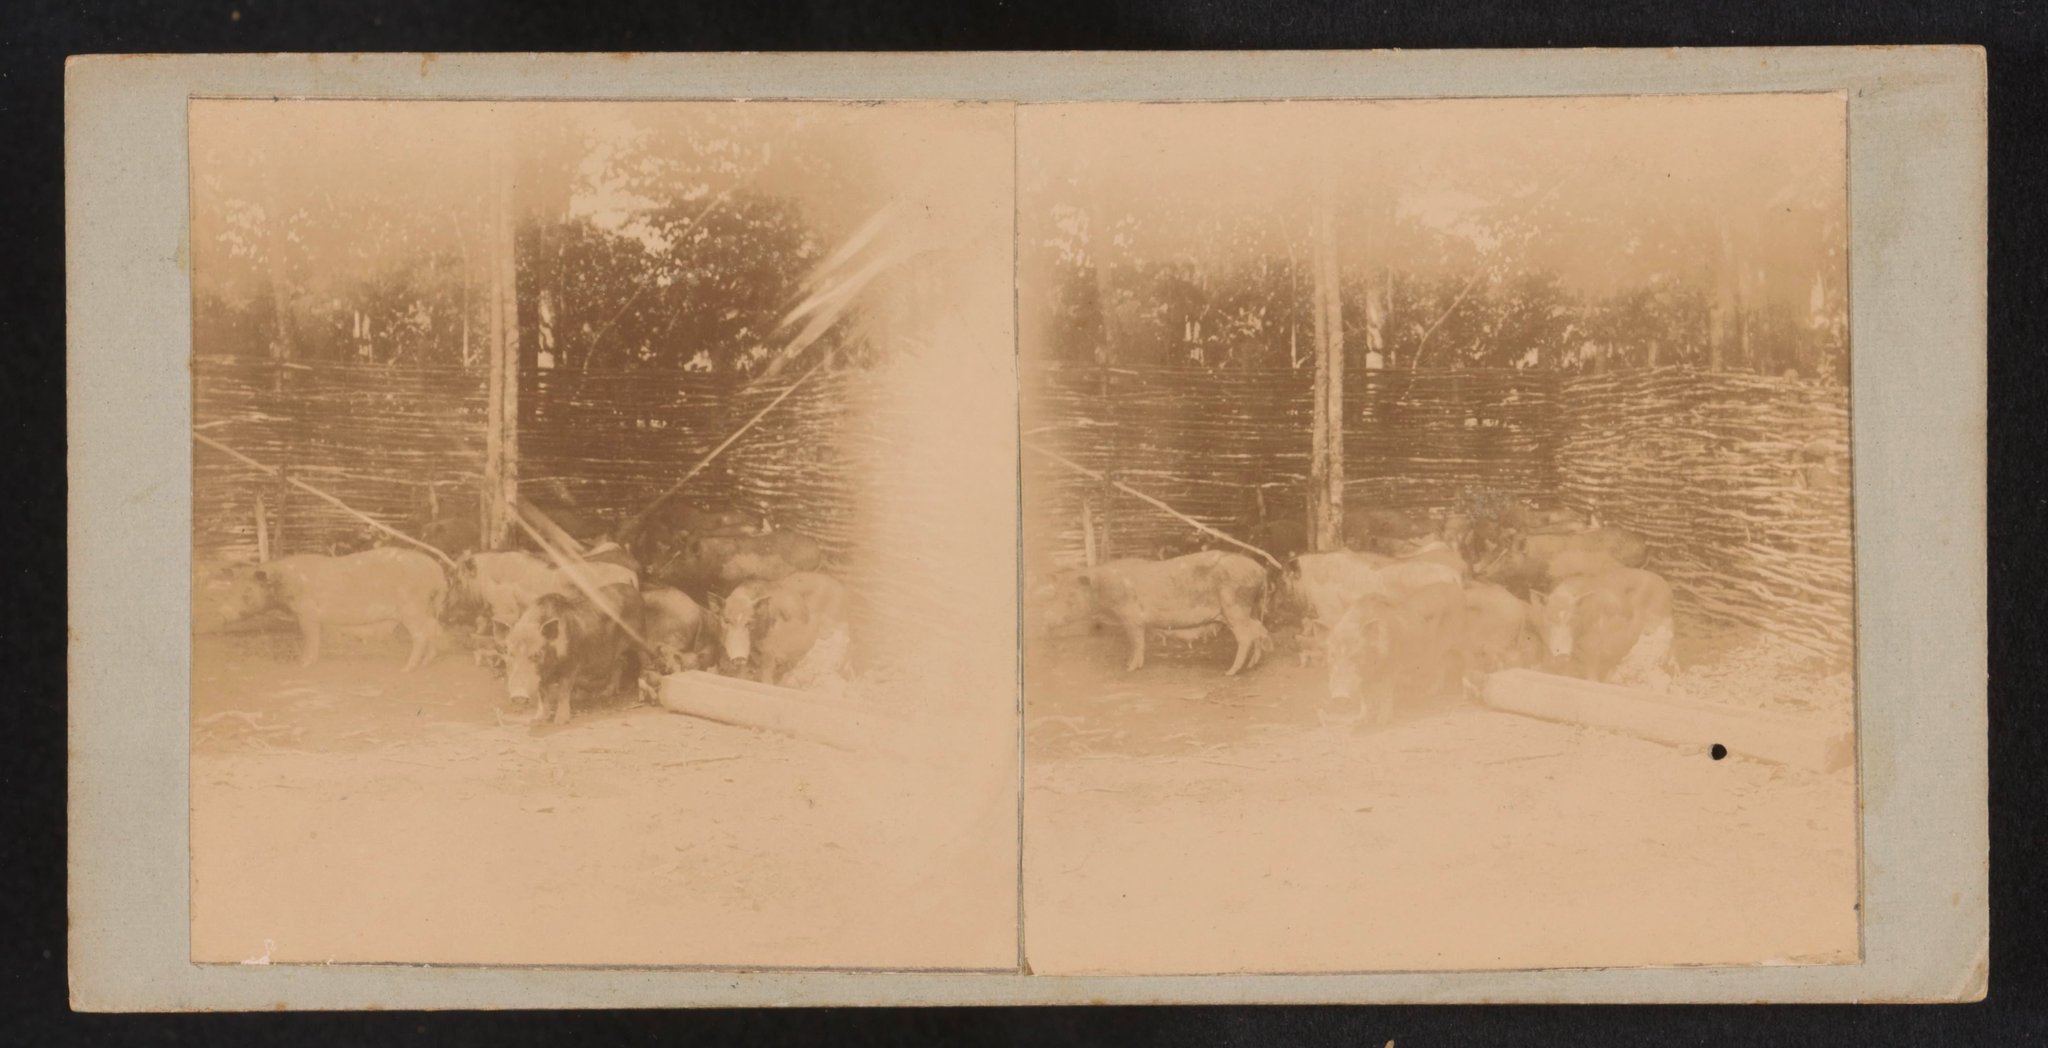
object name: stereograph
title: Varkensstal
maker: robert julius boers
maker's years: 1867-1932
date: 1900-1922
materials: cardboard, photographic support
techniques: gelatin silver print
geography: bangka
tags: robert julius boers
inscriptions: inscription: ‘Hok met Bankasche varkentjes’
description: Varkensstal op Banka. Onderdeel van een groep stereofoto's van Robert Julius Boers, chef van het staatsbedrijf de Banka-tinwinning op Banka, uit de periode ca. 1900-1922.